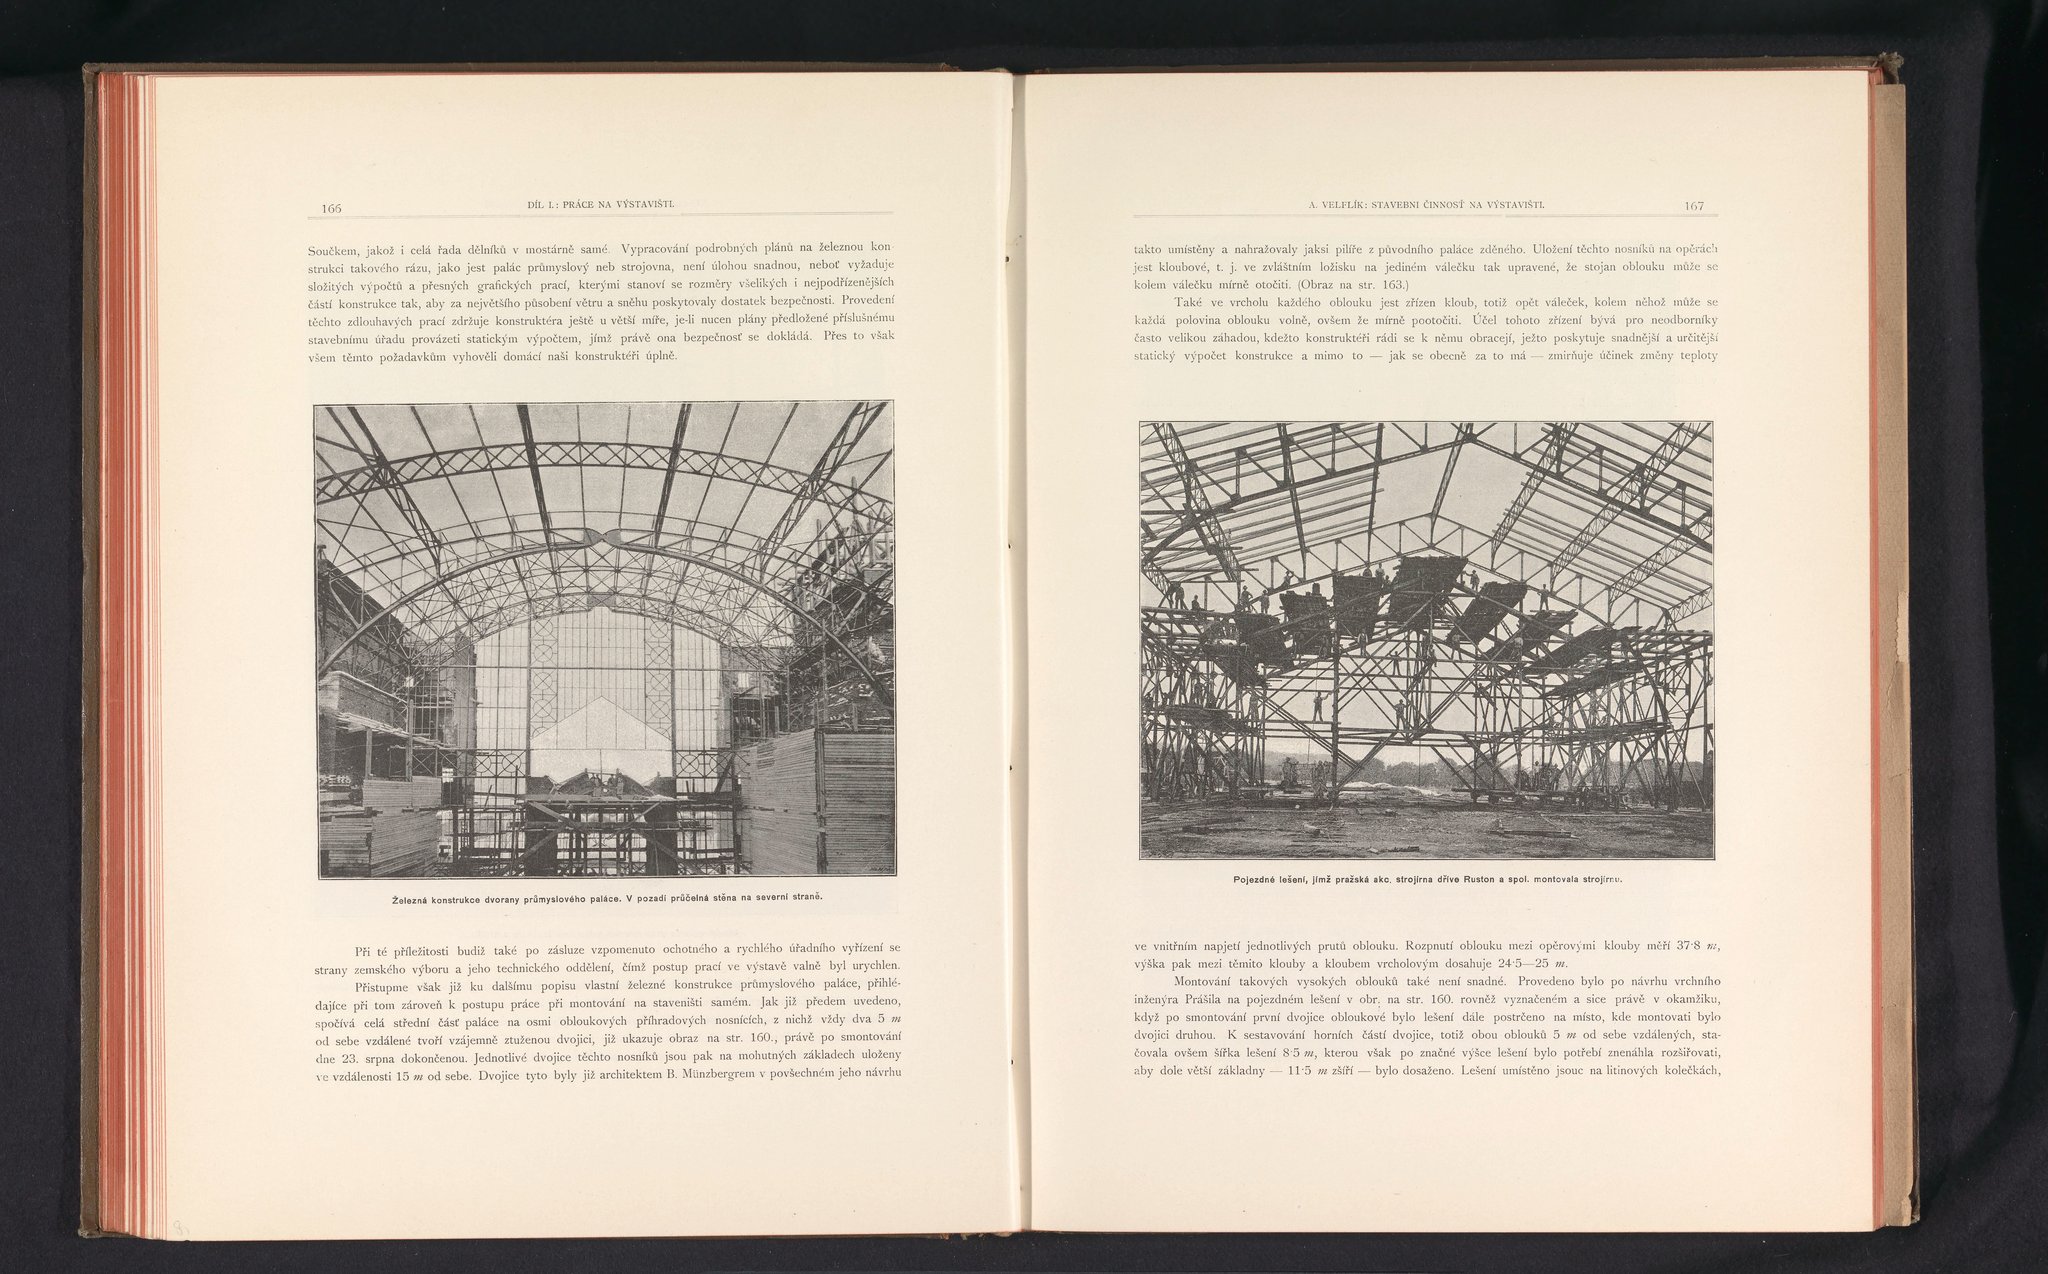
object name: page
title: Pojezdne leseni, jimz prazská akc strojírna drive Ruston a spol. montovala strojirnu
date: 1888-1893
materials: paper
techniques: autotype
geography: prague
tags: building-site